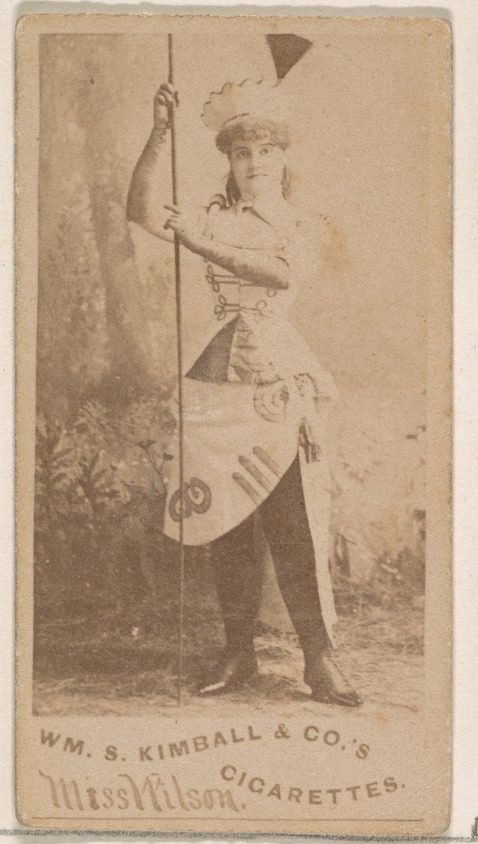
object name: photograph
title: Miss Wilson, from the Actresses series (N203) issued by Wm. S. Kimball & Co.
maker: william s. kimball & company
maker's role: publisher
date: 1889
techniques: color lithograph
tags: portraits,women,actresses